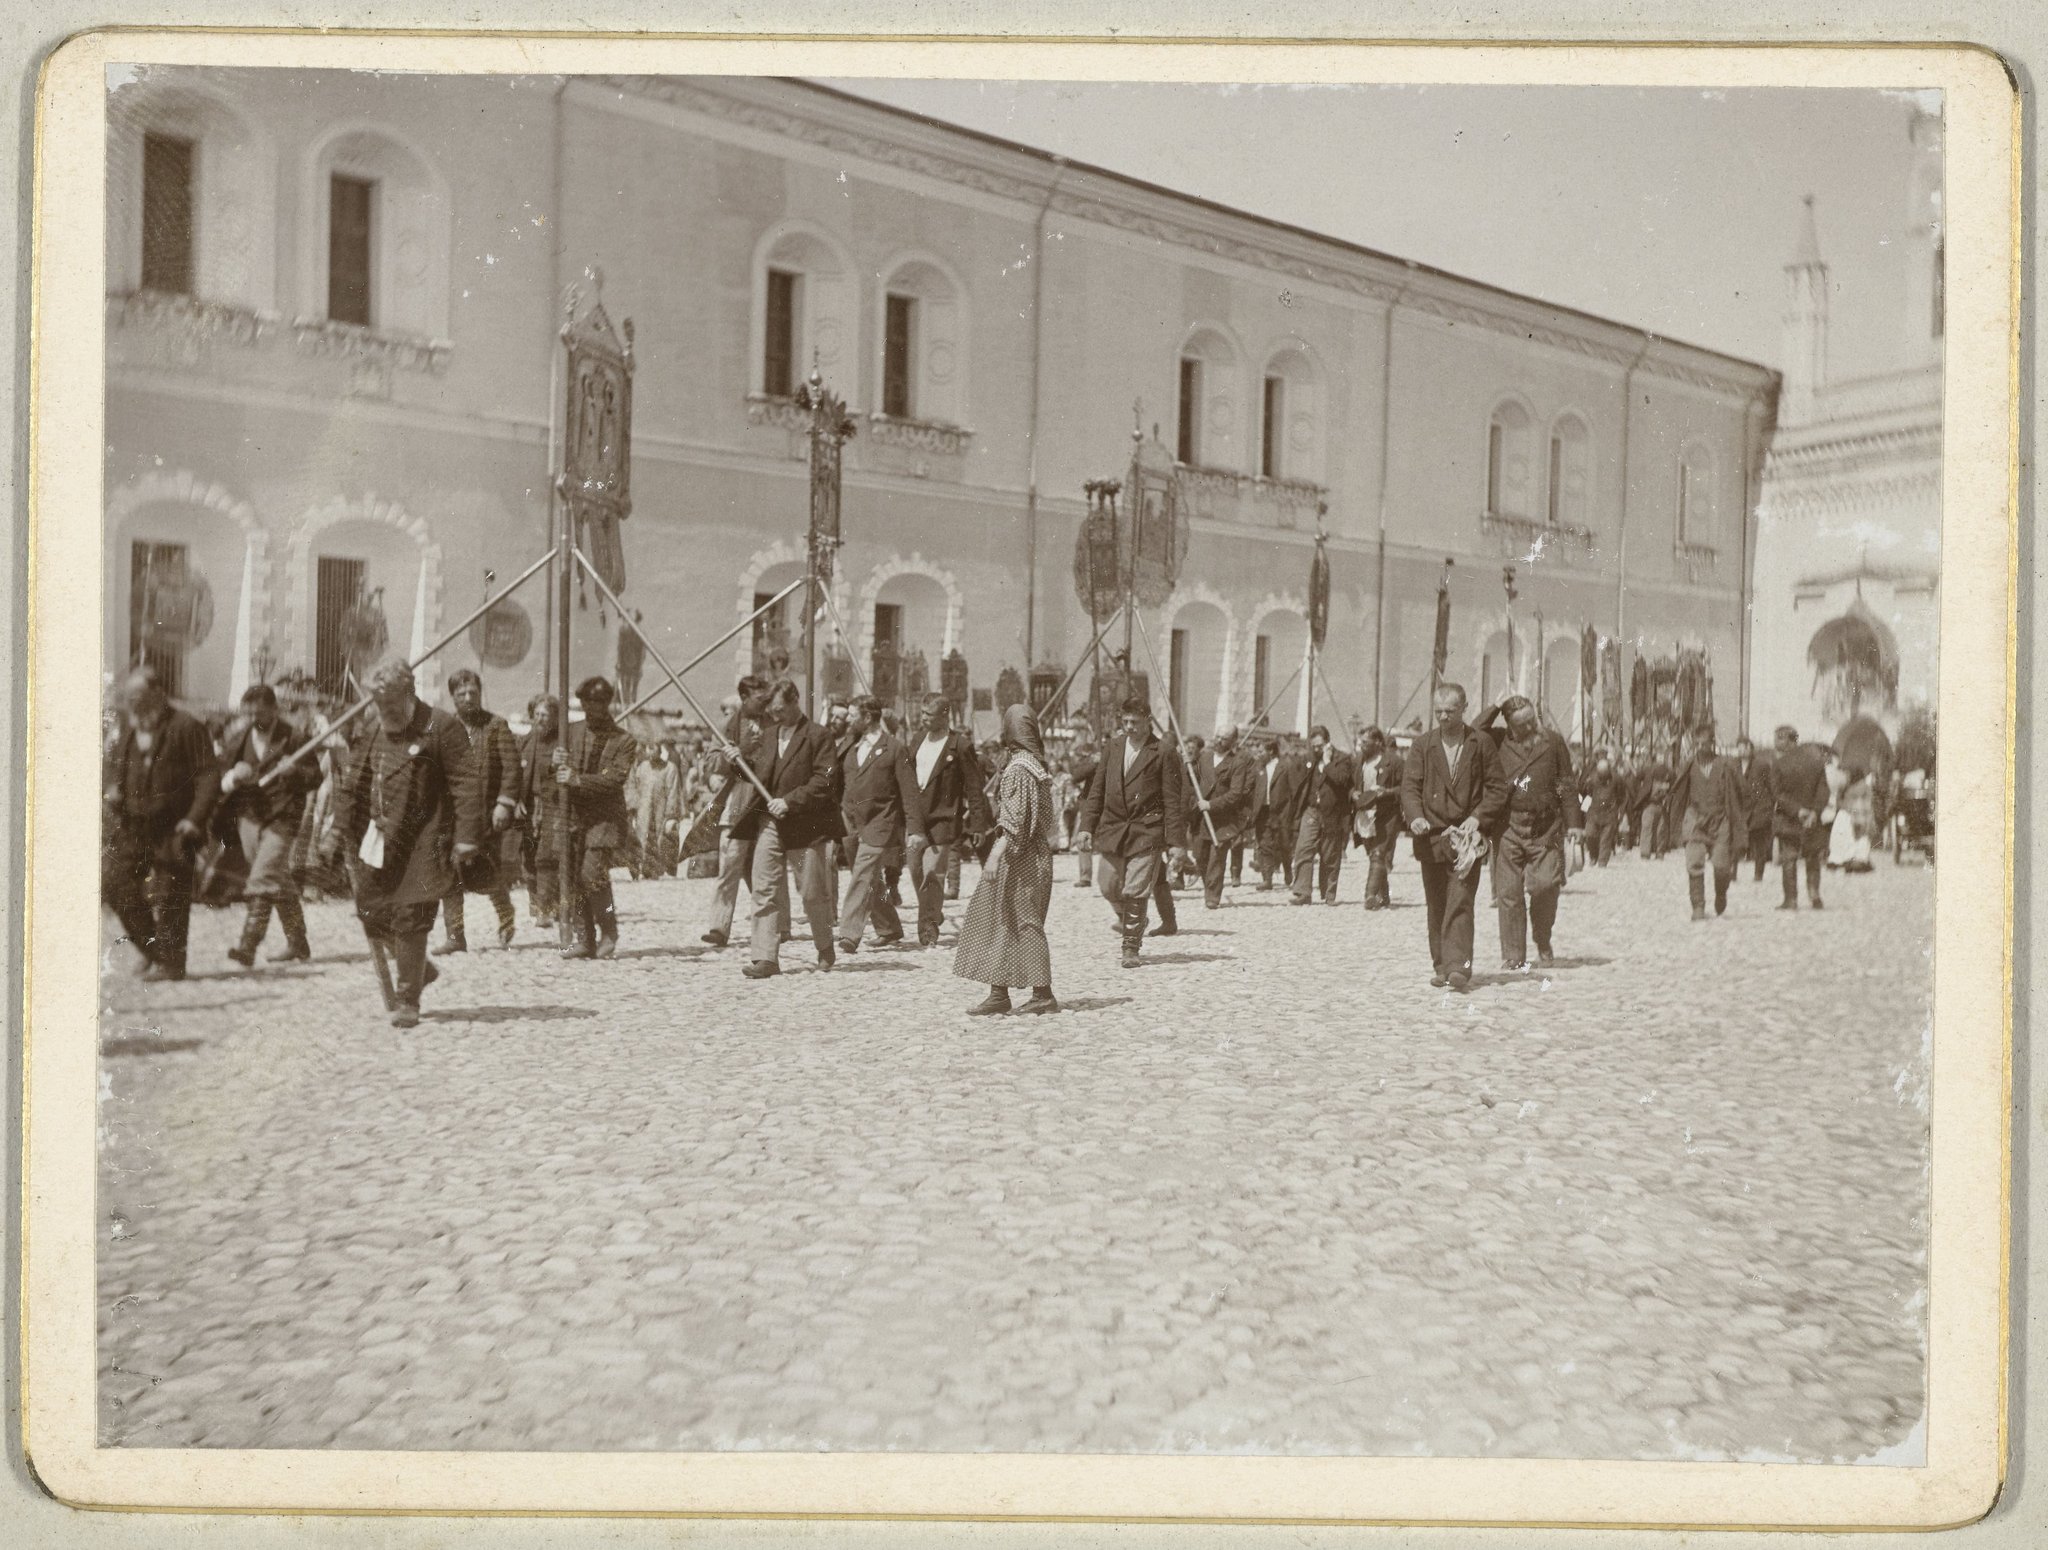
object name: photograph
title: Processie op het Kremlin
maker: henry pauw van wieldrecht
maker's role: fotograaf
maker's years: 1863-1912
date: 1898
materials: paper, photographic support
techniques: albumen print